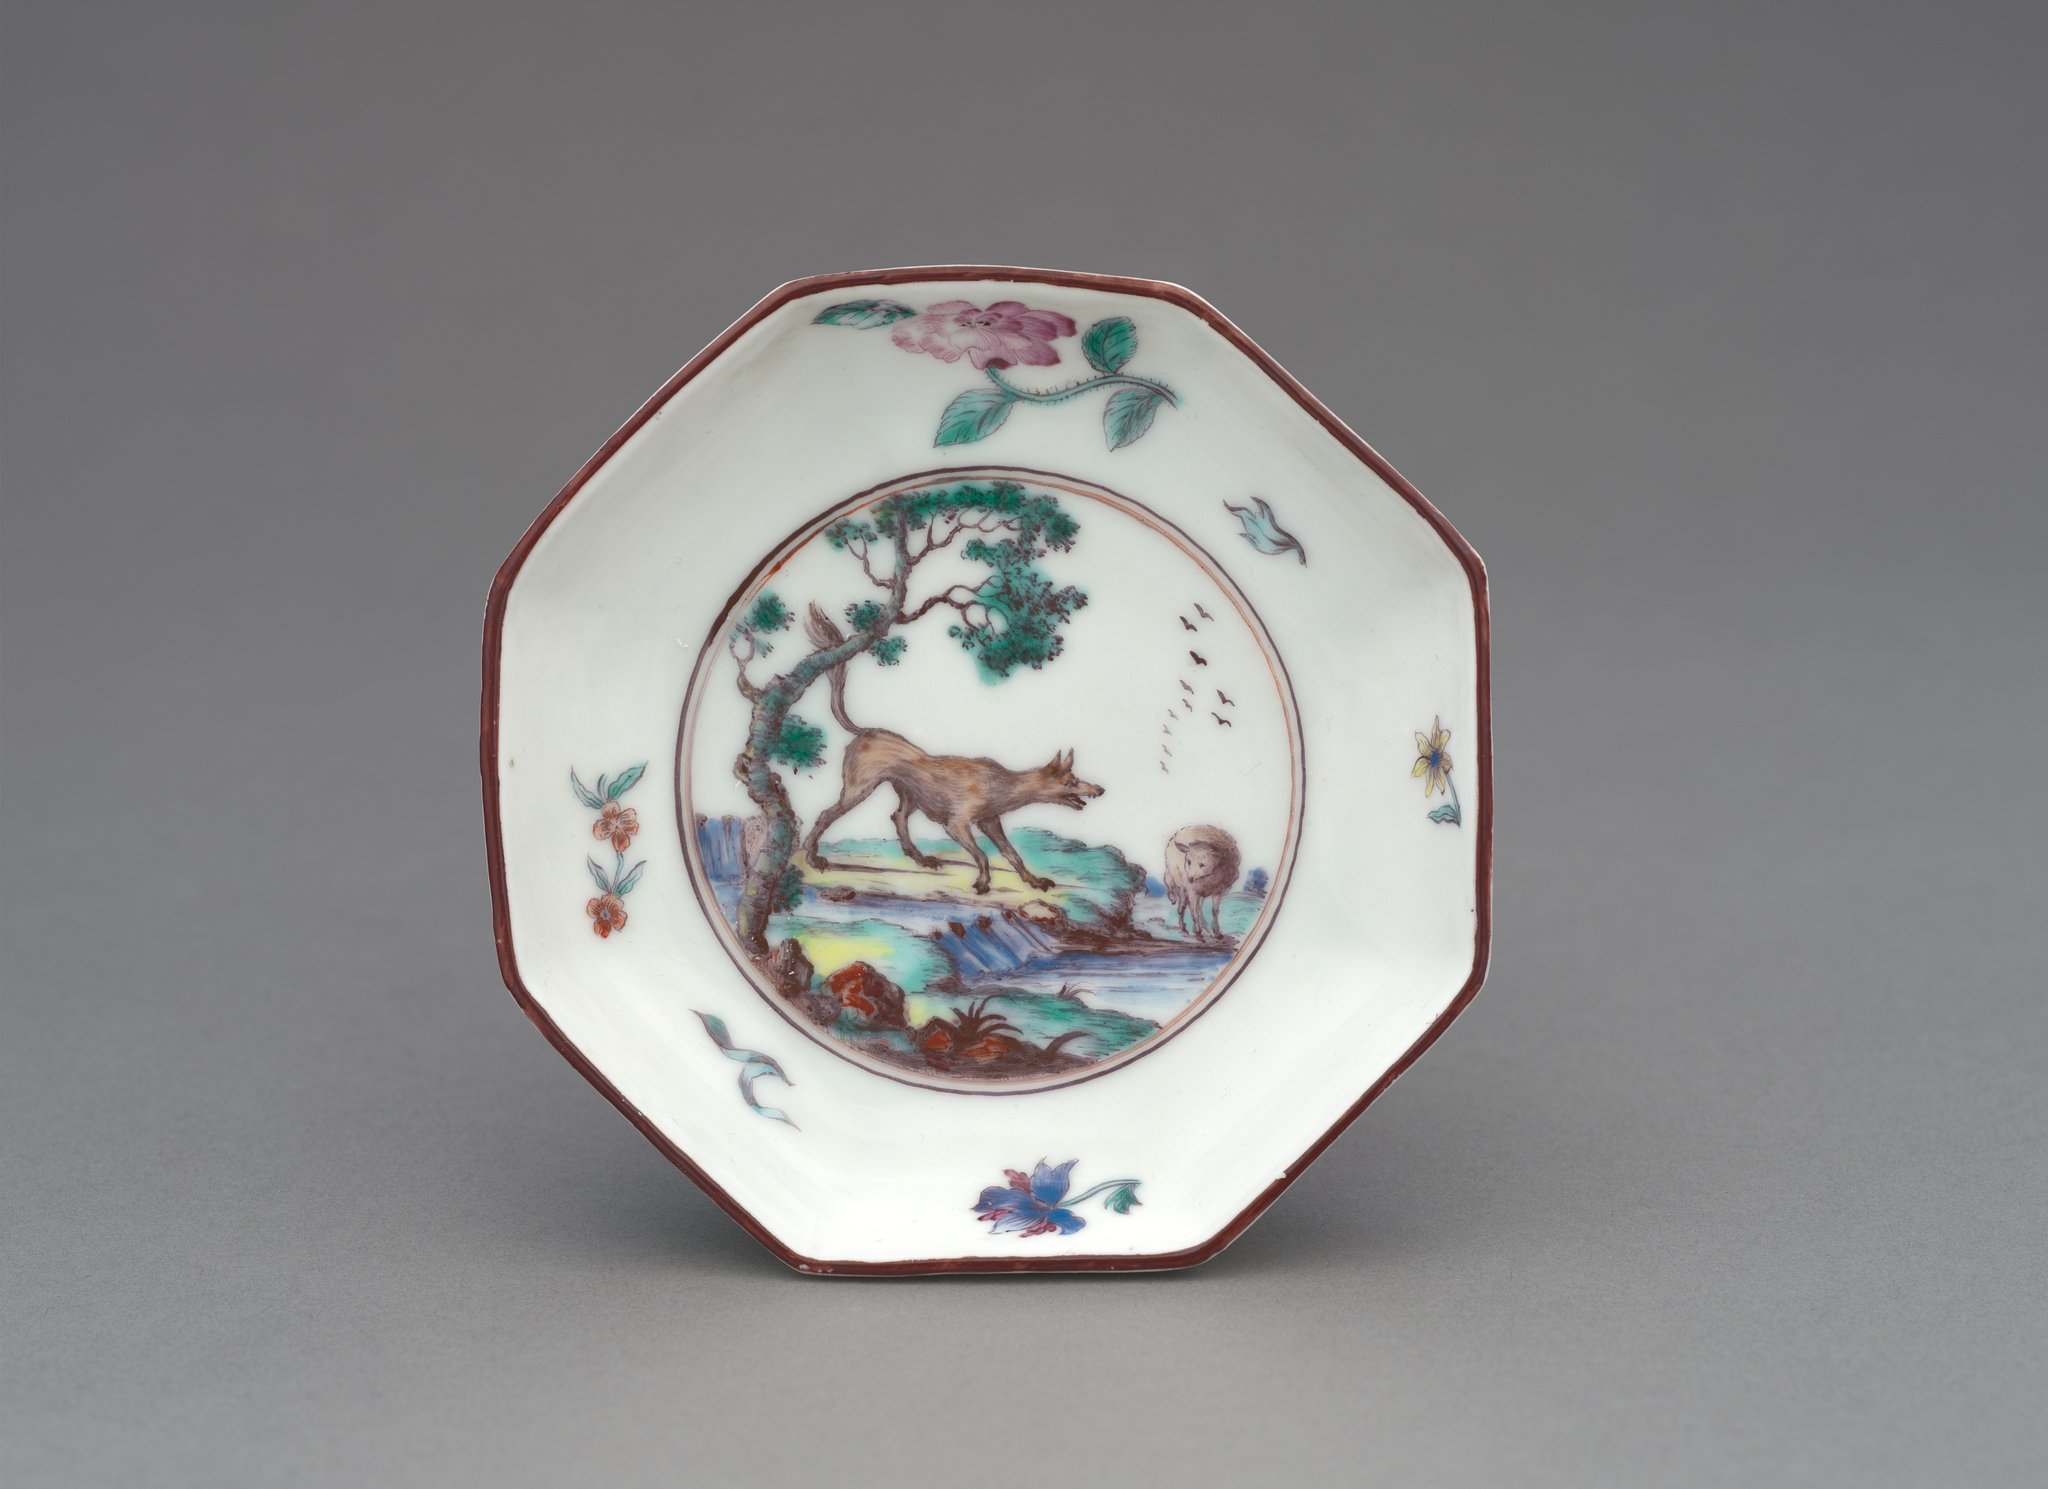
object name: saucer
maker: chelsea porcelain manufactory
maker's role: factory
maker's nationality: british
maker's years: 1744-1784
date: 1752-1755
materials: soft paste porcelain